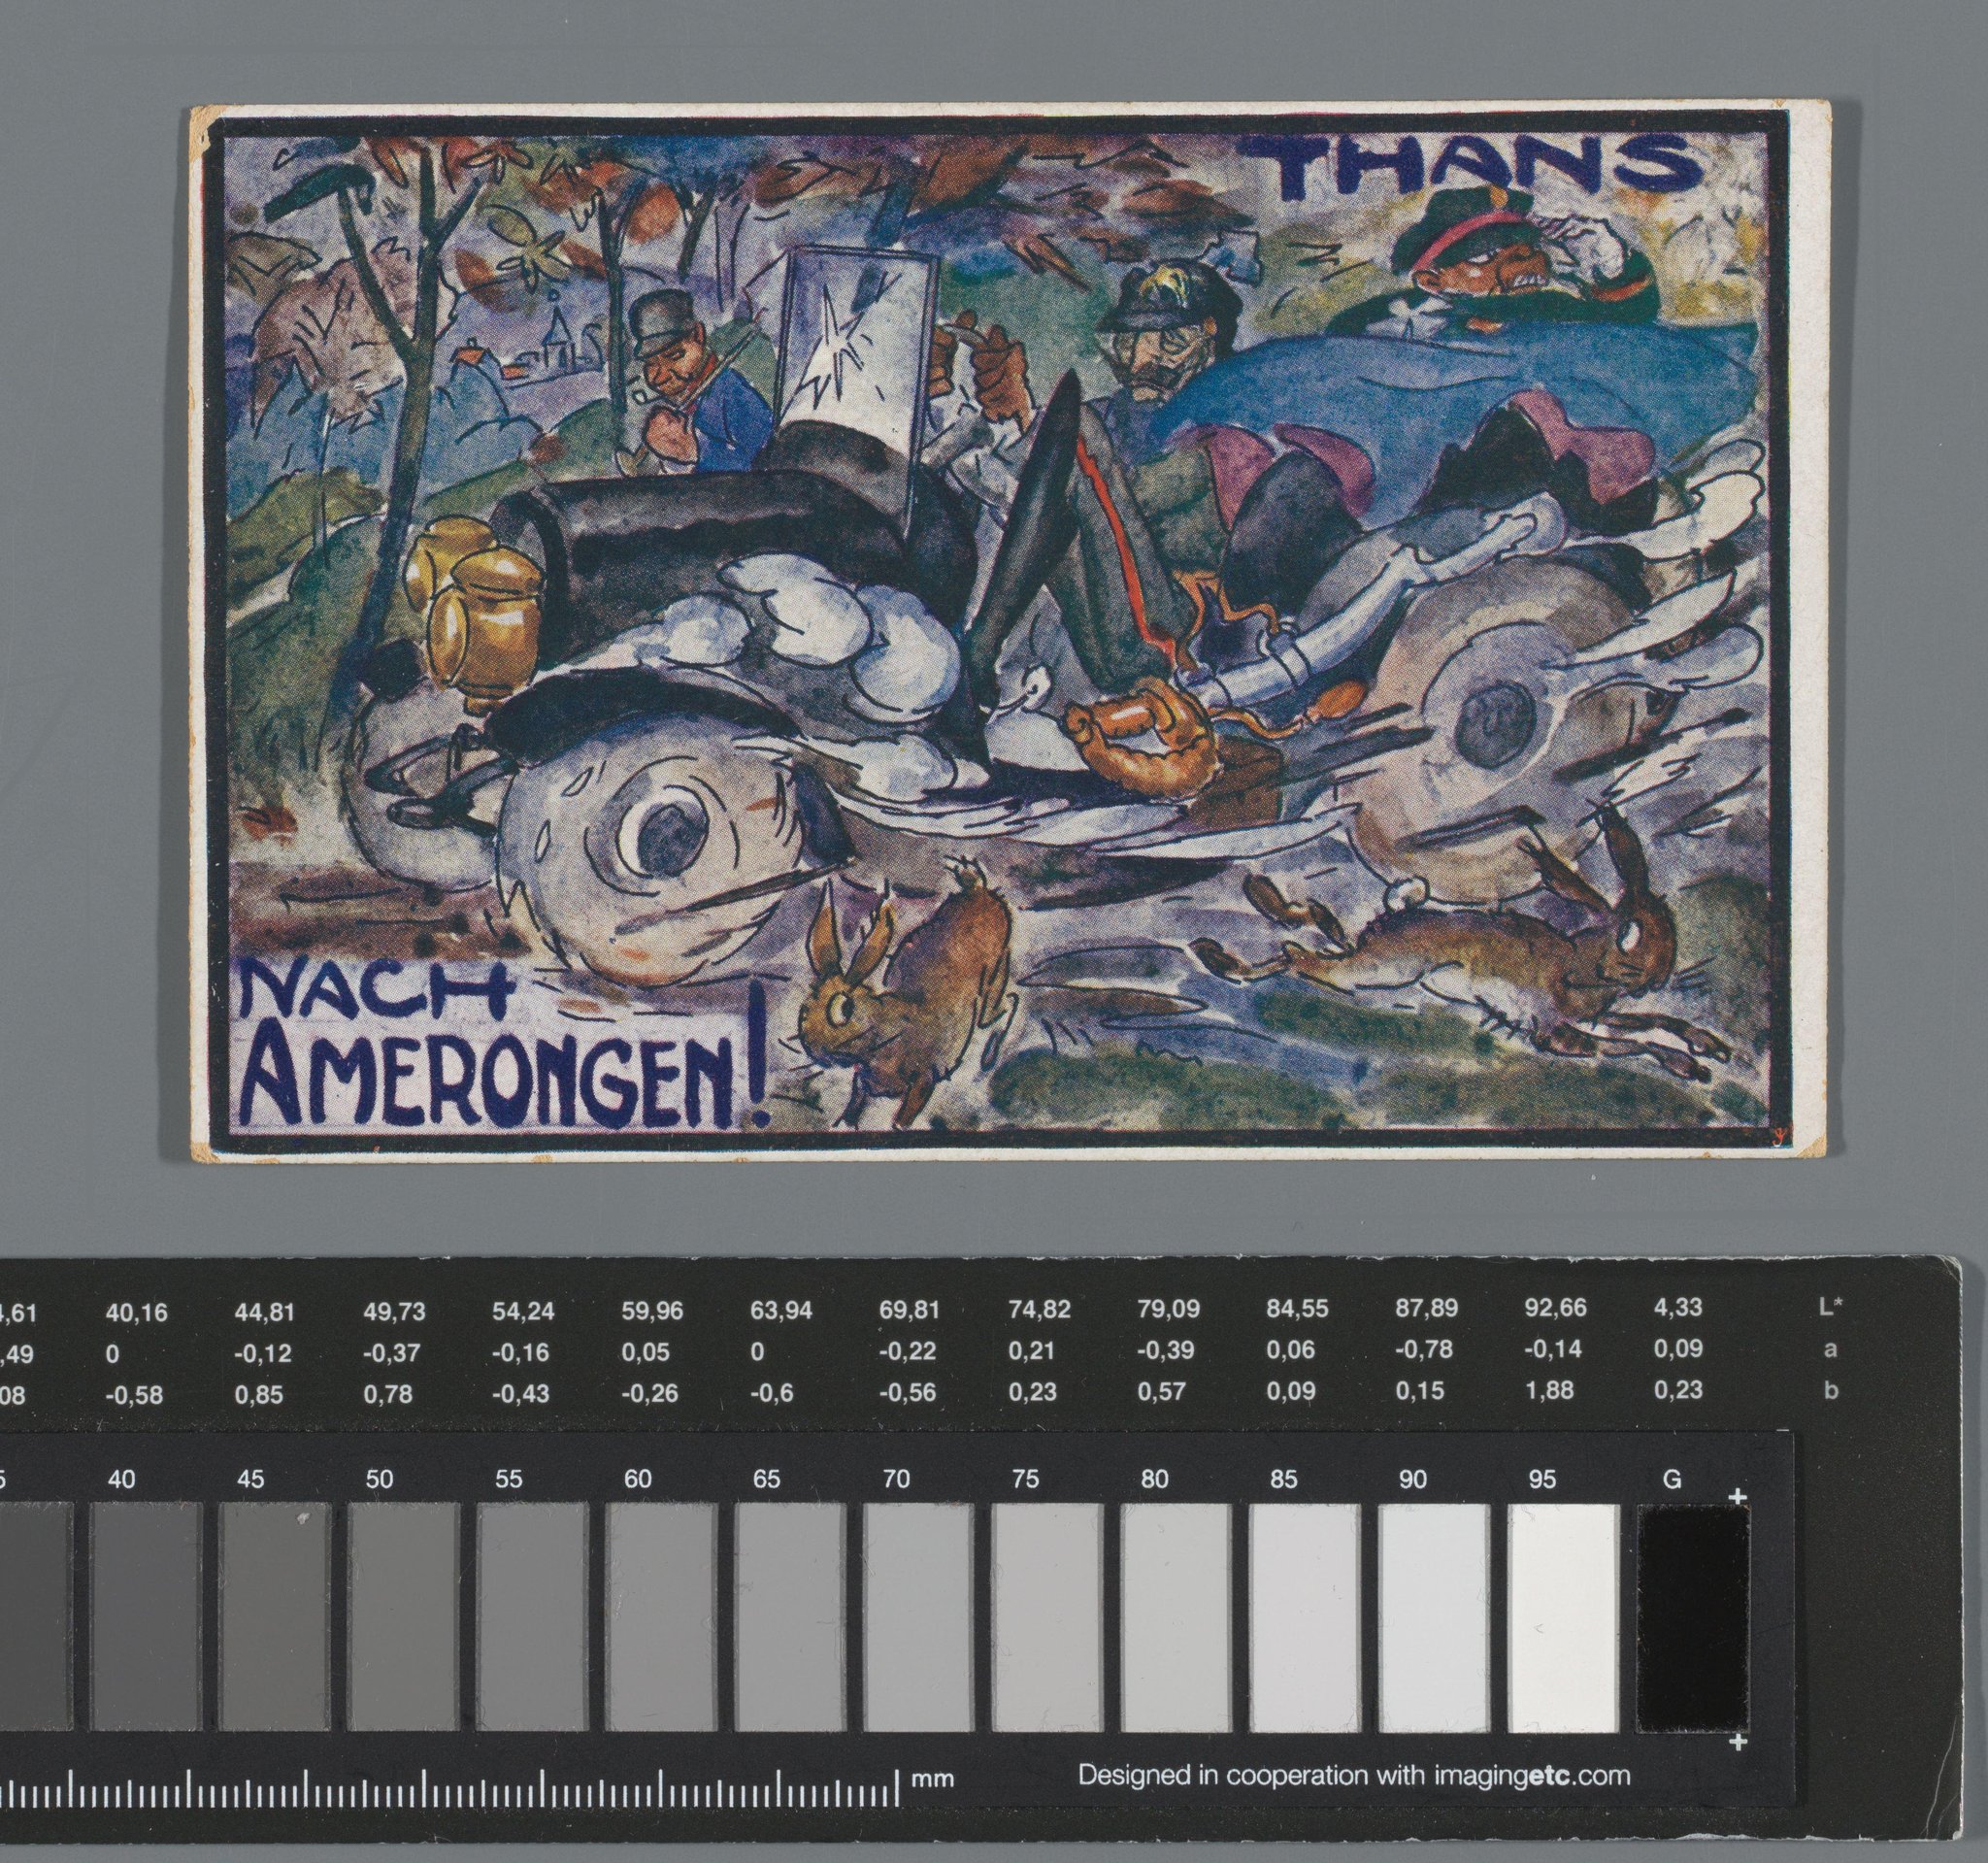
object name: ansichtkaart, prentbriefkaart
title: Thans. Nach Amerongen!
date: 1918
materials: cardboard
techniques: writing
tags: wilhelm ii (keizer van duitsland), traffic by road or path with motor-vehicle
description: Keizer Wilhelm II op een landweg in een auto waarvan de voorruit is gebarsten. Achter hem zit een man in uniform die salueert. Konijnen stuiven voor de auto weg en links loopt een man die naar de auto kijkt.